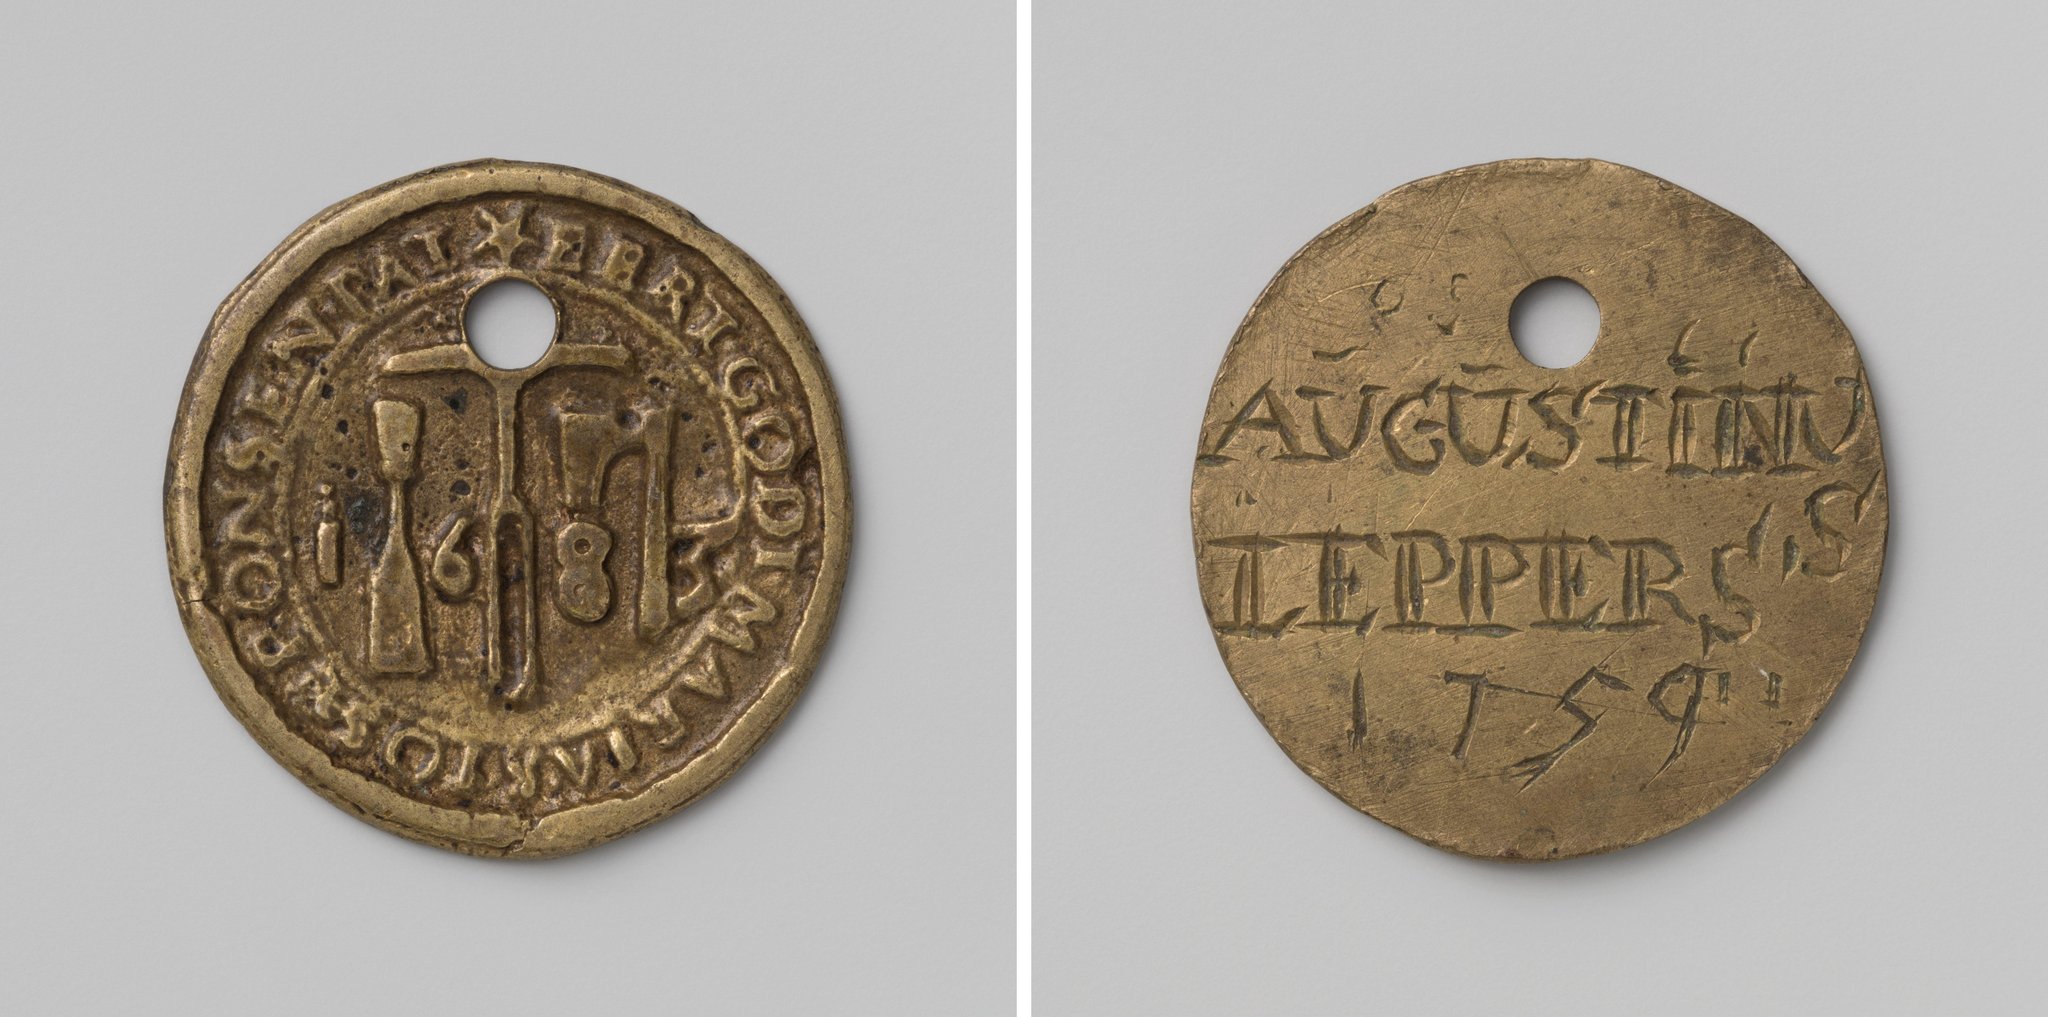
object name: medal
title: Timmerliedengilde van Maastricht, gildepenning van Augustinus Leppers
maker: Anonymous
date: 1759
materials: brass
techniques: casting, engraving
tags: maastricht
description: Messing penning met gat erin. Voorzijde: steekboor tussen beitel en bijl; daartussen jaartal binnen omschrift. Keerzijde: opschrift